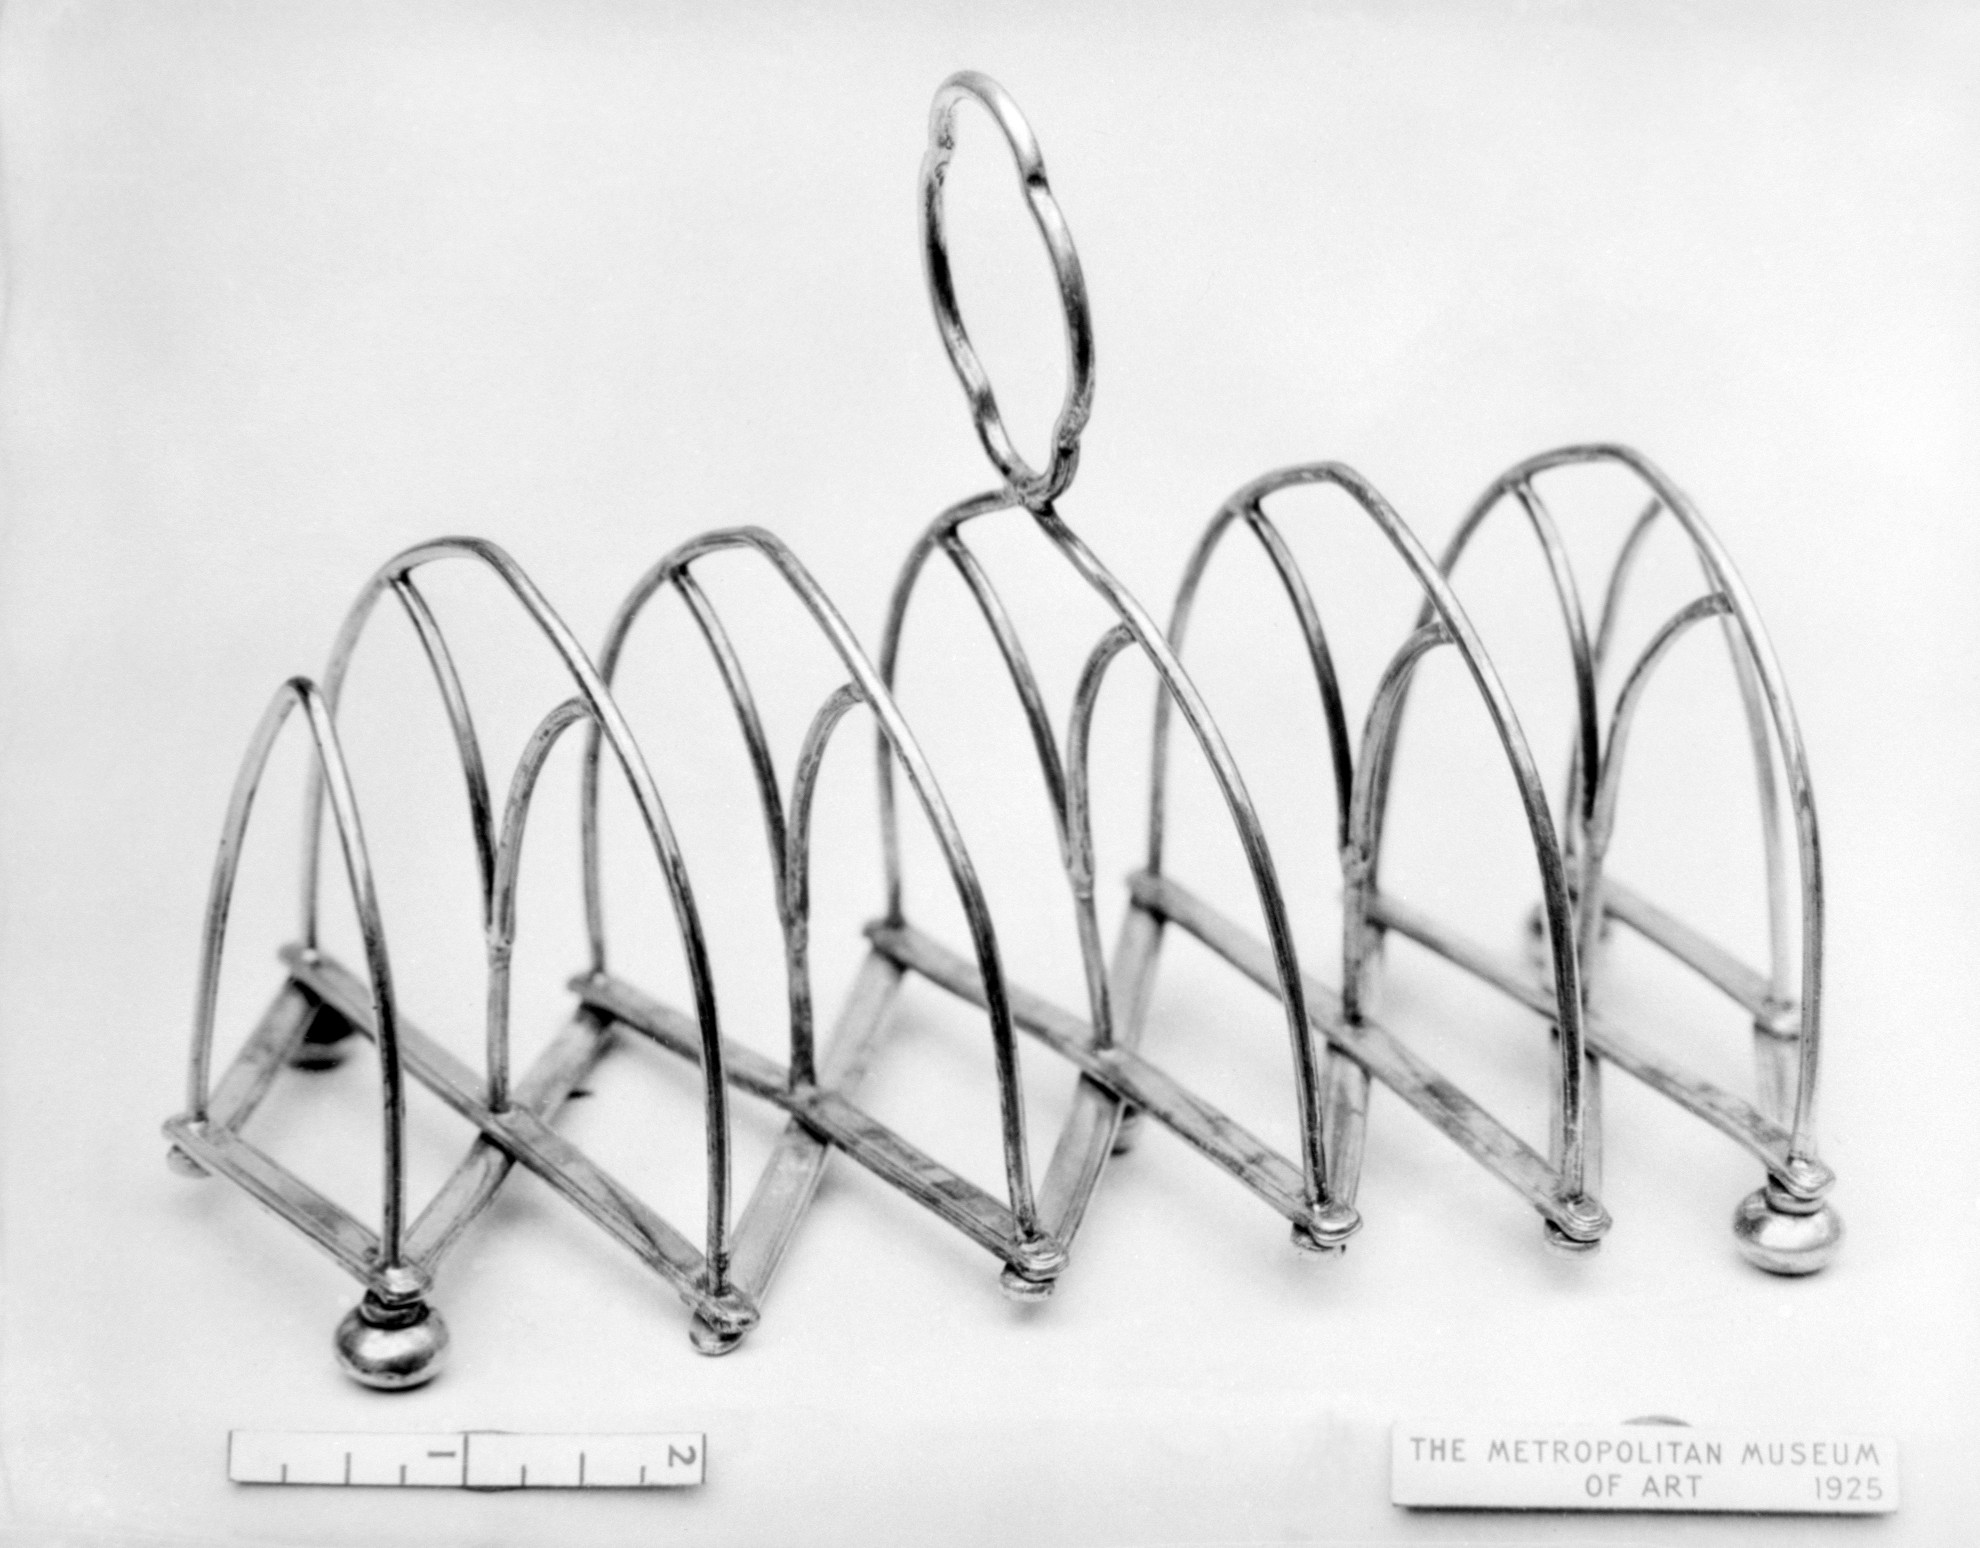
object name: toast rack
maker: roberts, cadman and co.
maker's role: maker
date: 1807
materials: metal